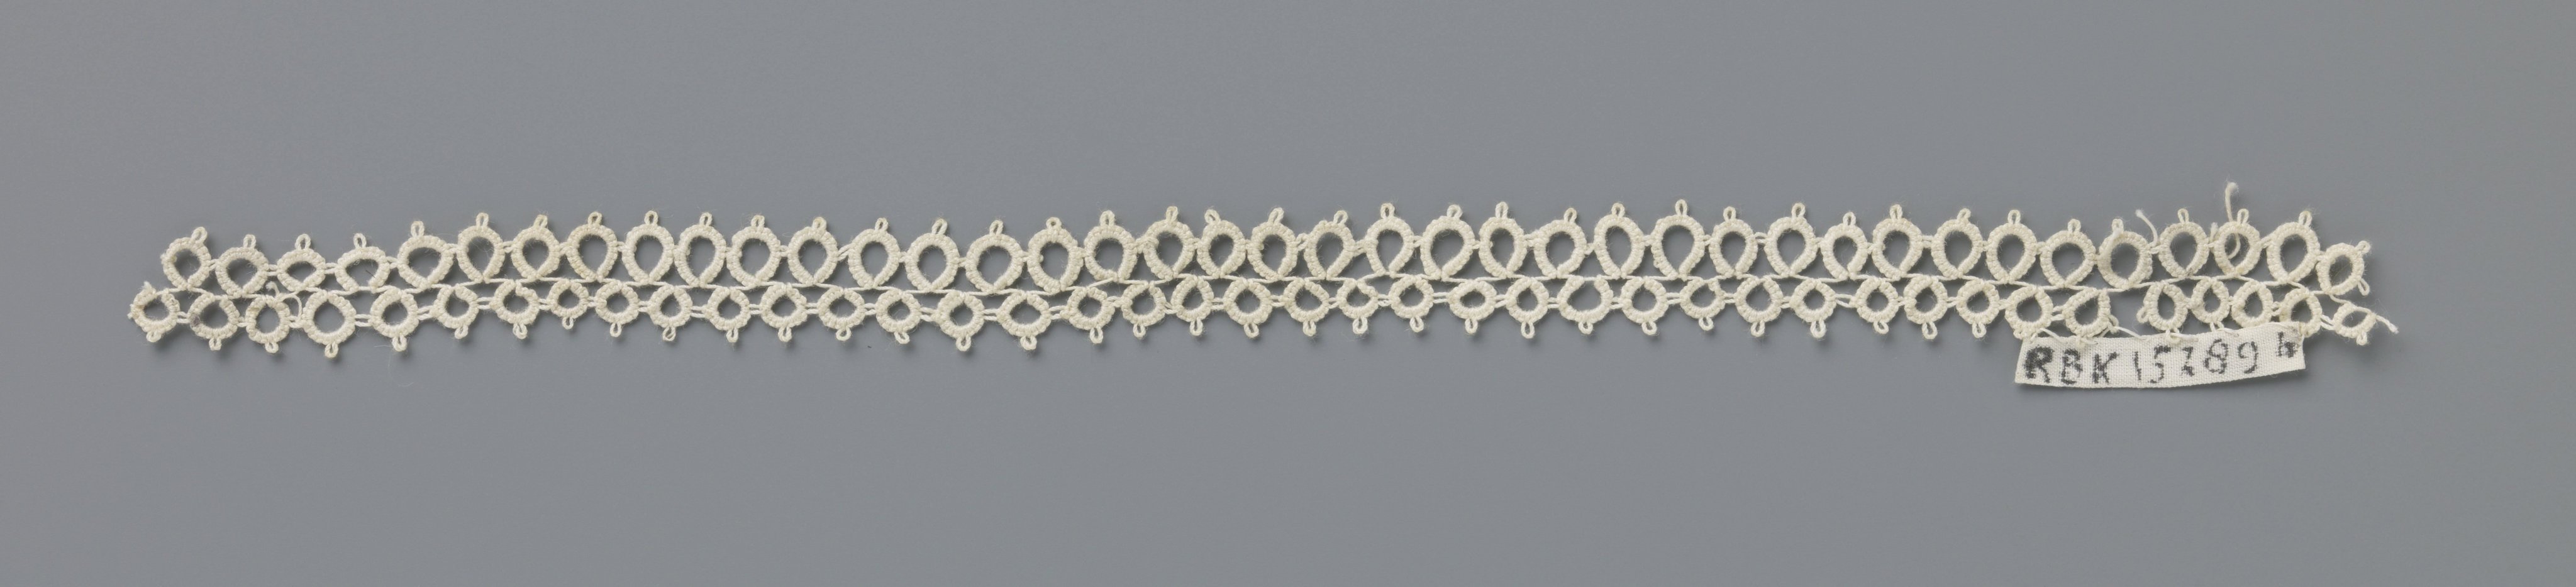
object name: mat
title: Kleedje van geknoopte kant met cirkeltje aan acht spandraden in het centrum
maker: Anonymous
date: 1900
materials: linen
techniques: tatting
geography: europe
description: Kleedje van naturelkleurige geknoopte kant: frivolité. Rond model. Rozet met druppelvormig lusjes met in het centrum een cirkeltje aan acht spandraden. Om de rozet ronde lusjes met picots en daar omheen de schulpenrand die bestaat uit boogjes met picots.